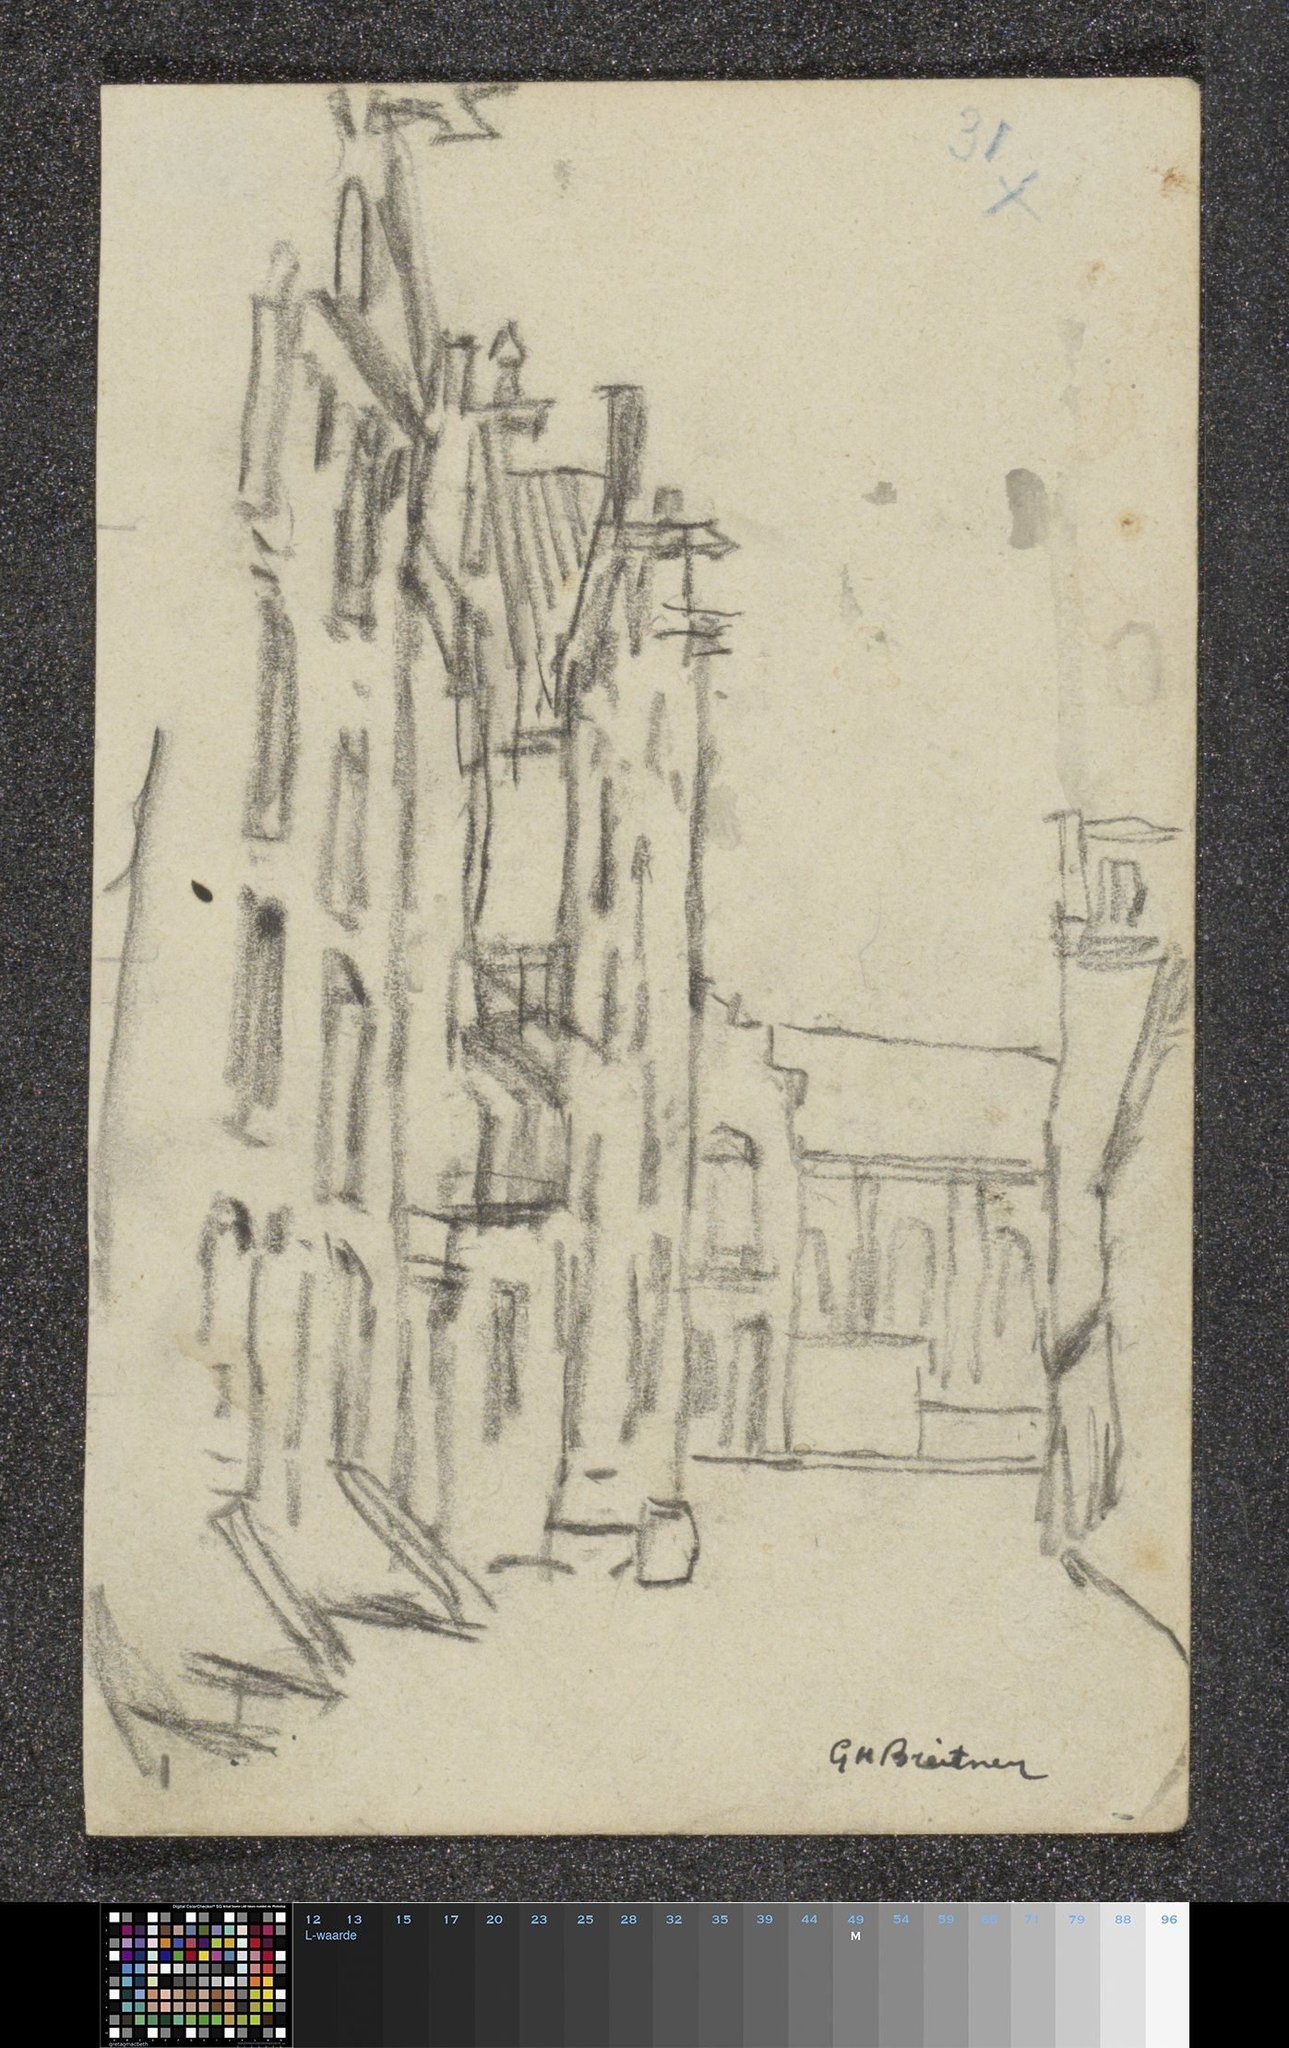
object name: drawing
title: Gezicht op een straat in Amsterdam, mogelijk op de Westelijke Eilanden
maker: george hendrik breitner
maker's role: draughtsman, painter, print maker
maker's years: 1857-1923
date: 1912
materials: chalk, paper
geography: amsterdam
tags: church (exterior) - qq - small church, chapel, street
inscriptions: signature: ‘G H Breitner’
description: In de verte mogelijk een kapel of kerk met een trapgevel.